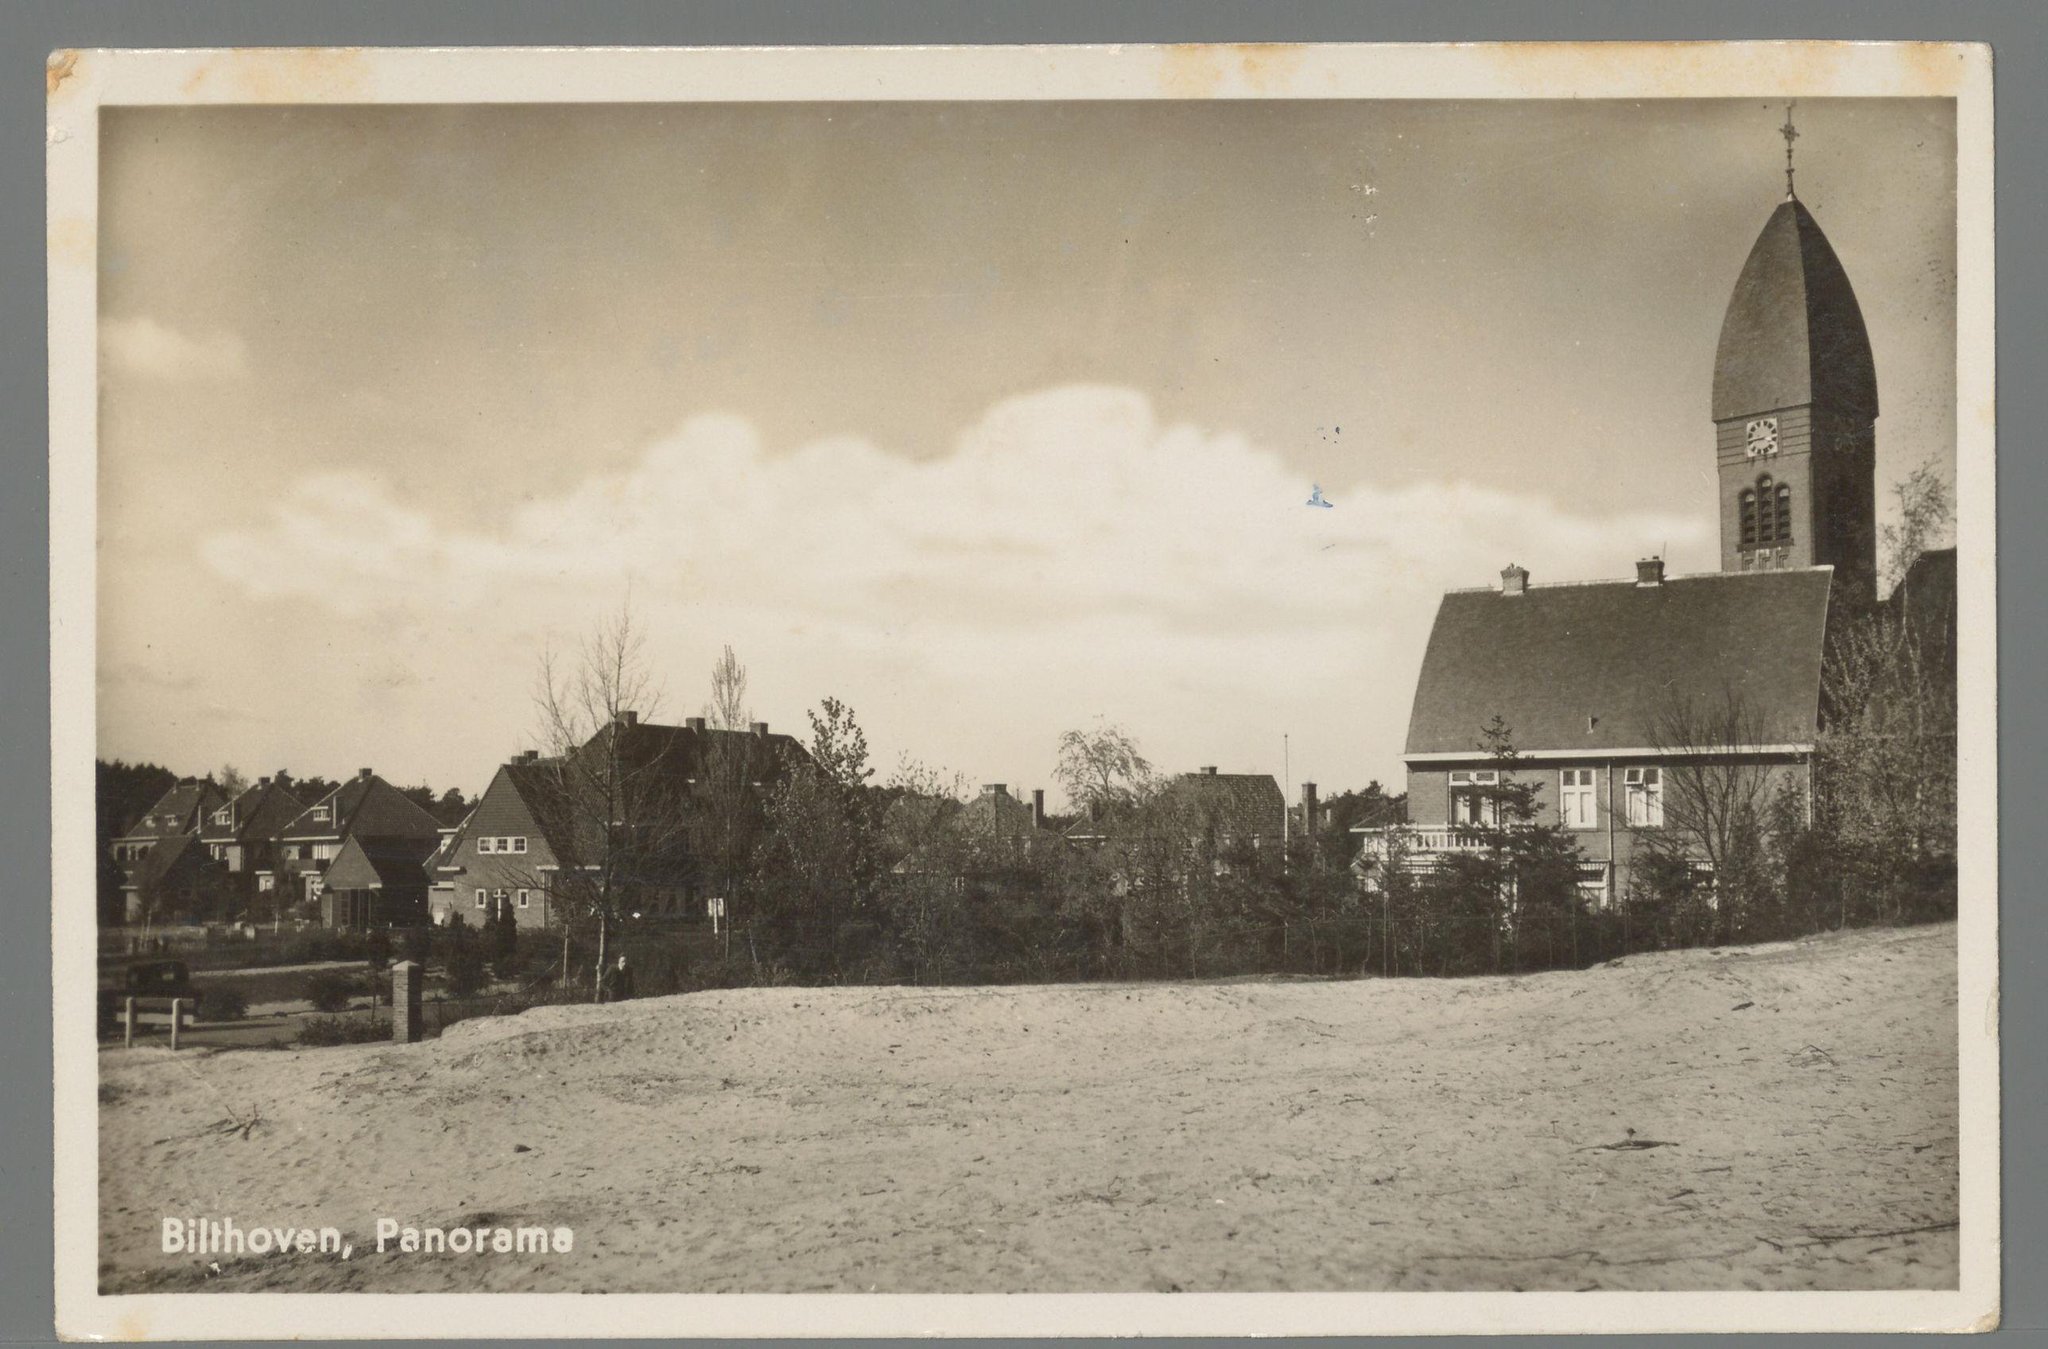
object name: ansichtkaart, prentbriefkaart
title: Bilthoven, panorama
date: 1929-1941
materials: paper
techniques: gelatin silver print, writing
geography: bilthoven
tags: church (exterior), prospect of city, town panorama, silhouette of city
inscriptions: postage stamp